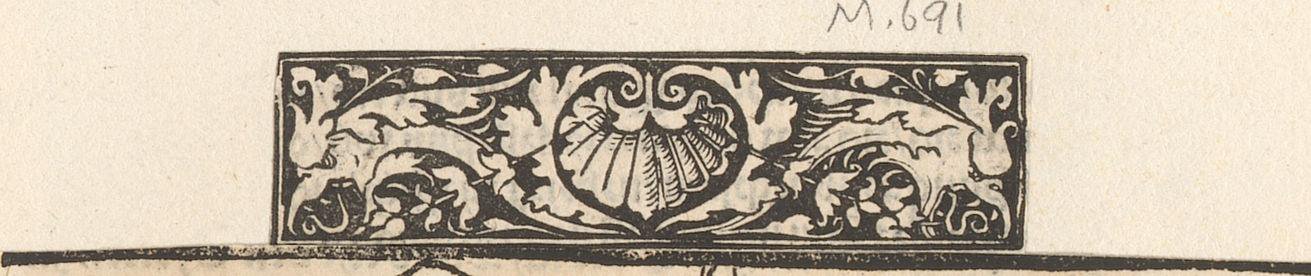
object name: album leaf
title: Schelp en ornamenten met bladmotief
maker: Anonymous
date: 1514-1532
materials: paper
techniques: letterpress printing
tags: foliage ~ ornament, scallop, shell ~ ornament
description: Deze prent is gebruikt als ornament in: Petrarca, Francesco. Von der Artzney bayder Glück, des guten und widerwertigen: unnd weß sich ain yeder inn Gelück und Unglück halten sol (...). Augsburg: Heinrich Steiner, 1532. Deze uitgave is ook bekend onder de titel 'Trostspiegel in Glück und Unglück'.